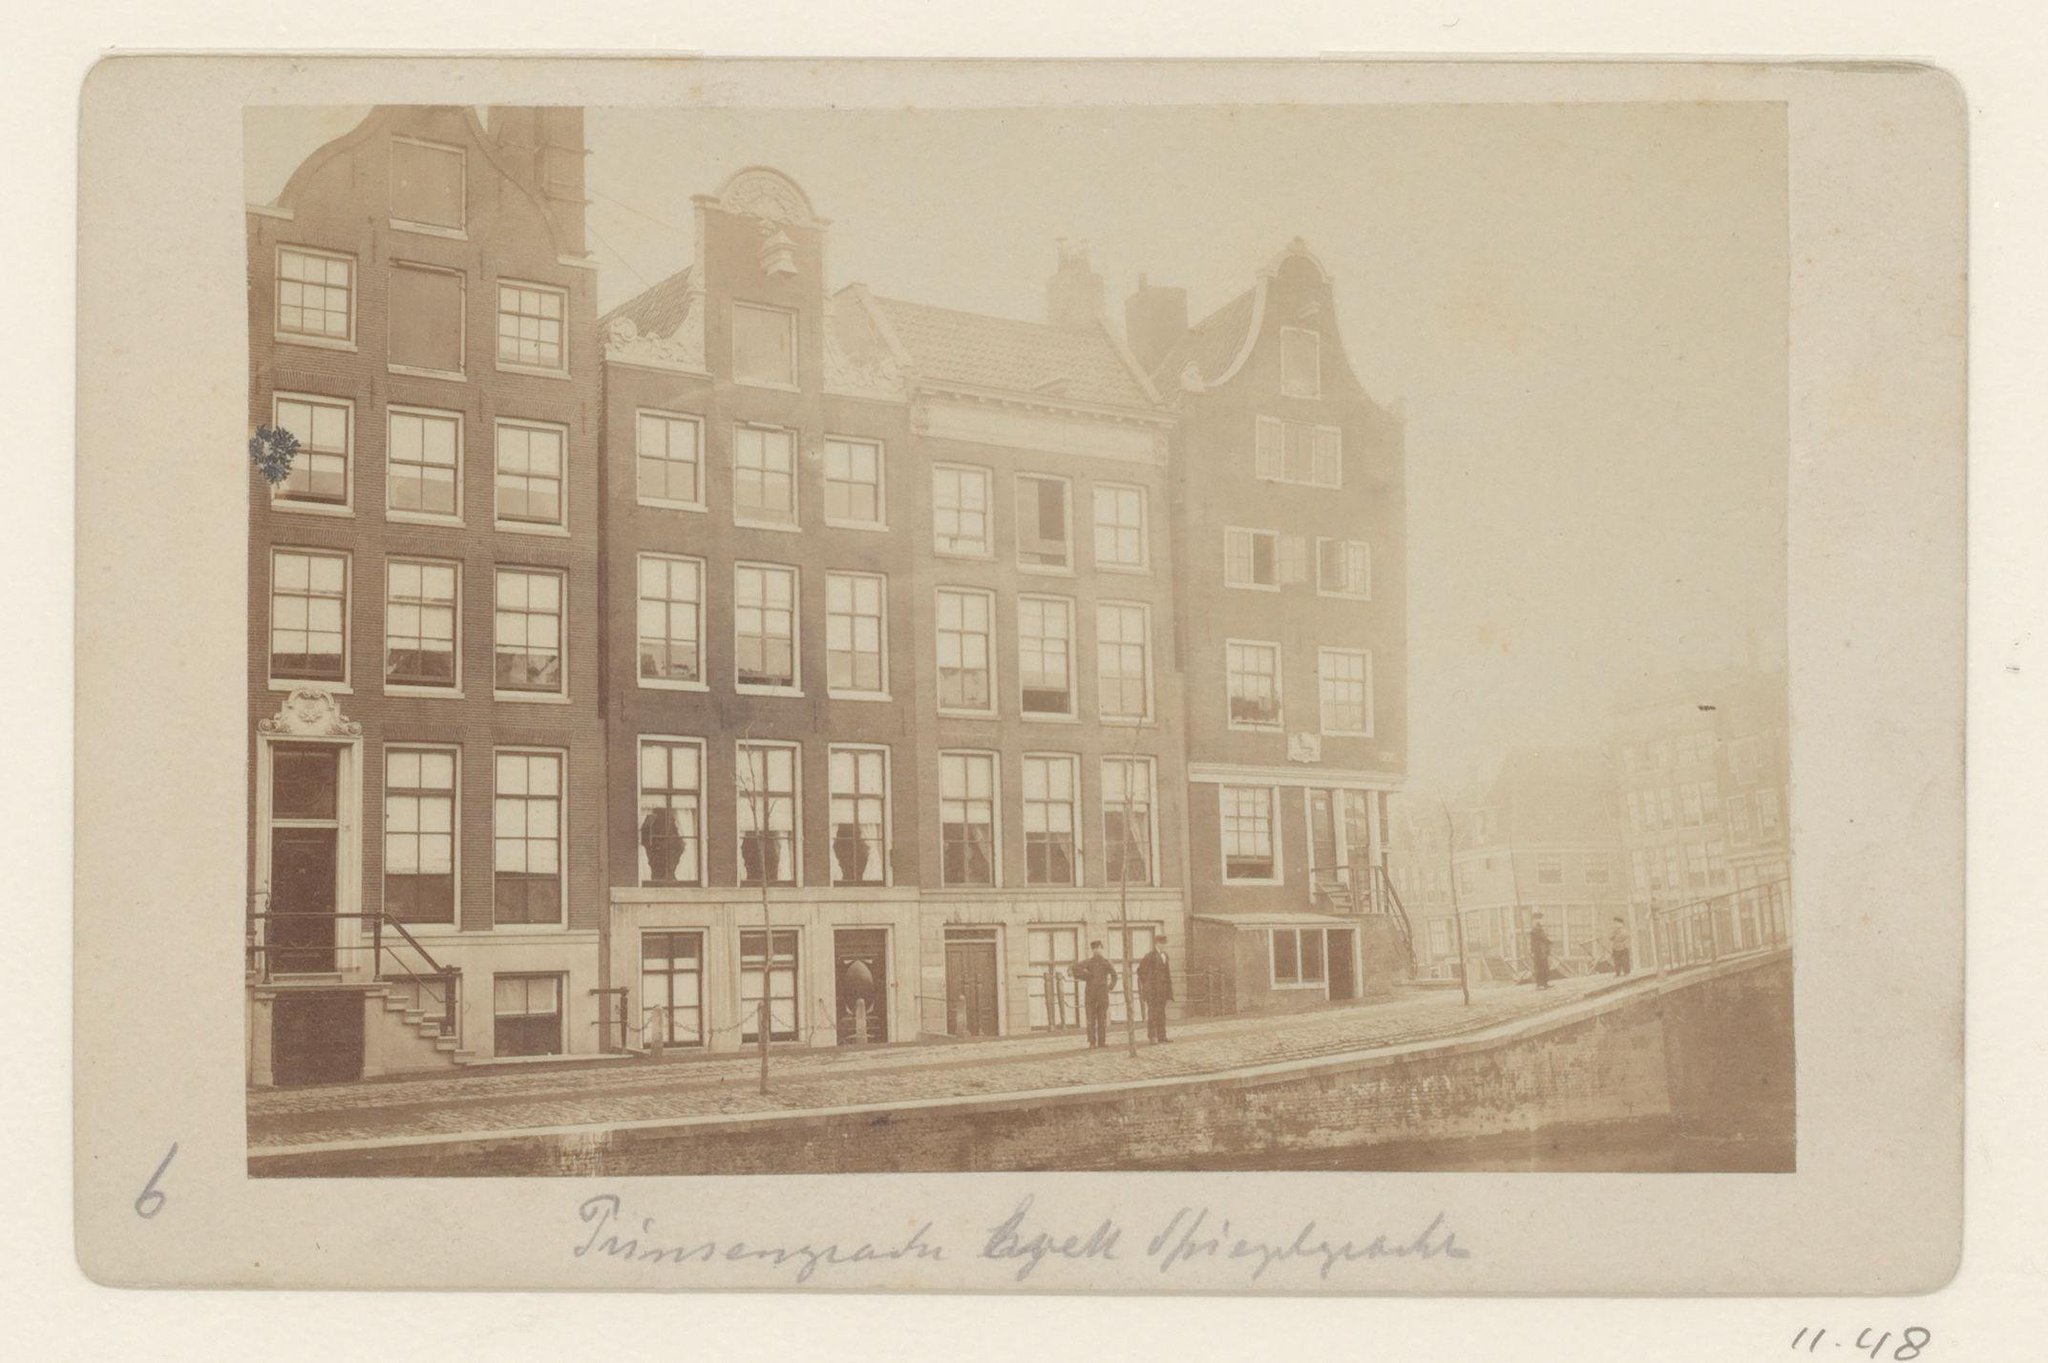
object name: cabinet photograph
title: Gezicht op de Prinsengracht, hoek Spiegelgracht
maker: Anonymous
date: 1850-1915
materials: cardboard, paper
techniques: albumen print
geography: amsterdam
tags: city-view in general; 'veduta', canal, the usual house or row of houses, street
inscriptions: inscription: ‘Prinseng: hoek spiegelstr gracht / Het hoekhuis is in ongeveer 1908 / afgebroken’, collector's mark: ‘11.48’ Lugt 1641b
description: Onderwerpsrubriek binnen de Atlas Amsterdam: Prinsengracht, Korte Prinsengracht, Prins Hendrikkade. Zie ook Portefeuille 1: gezichten van het IJ op de stad.